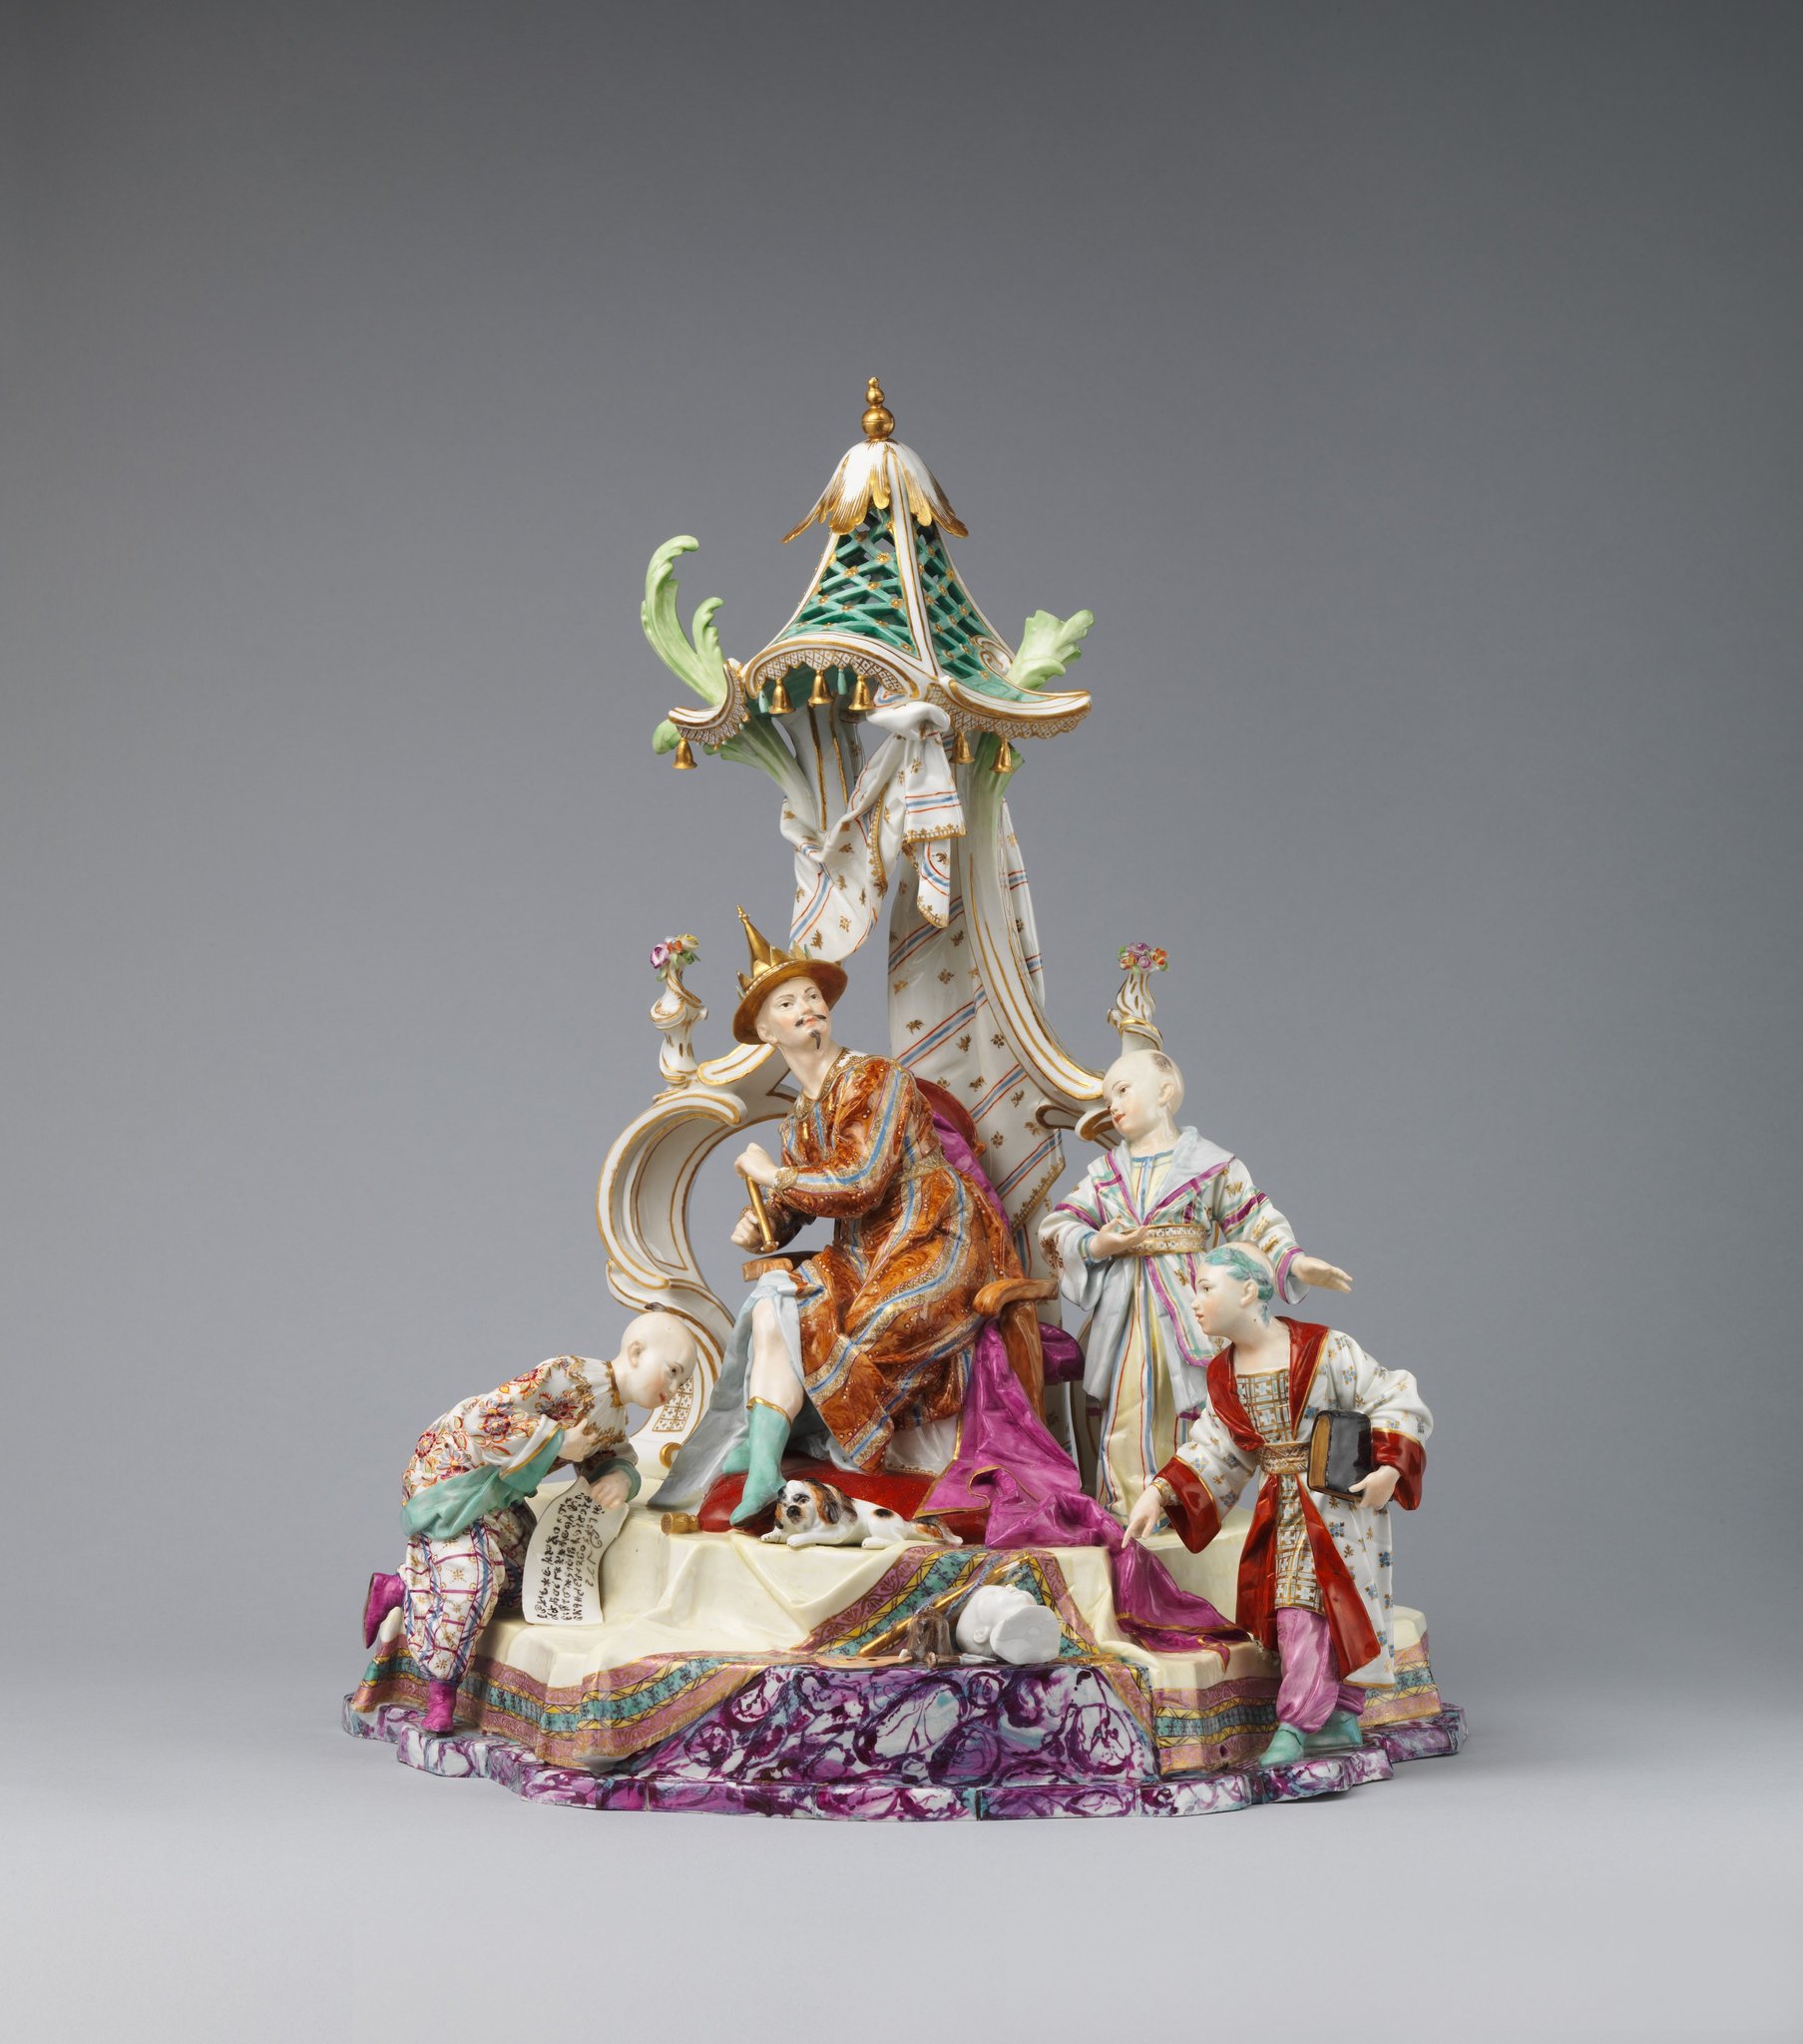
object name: group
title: The Chinese Emperor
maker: höchst manufactory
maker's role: manufactory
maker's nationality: german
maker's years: 1746-1796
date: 1766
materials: enamel, gold, hard paste porcelain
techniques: polychrome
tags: boys,men,dogs